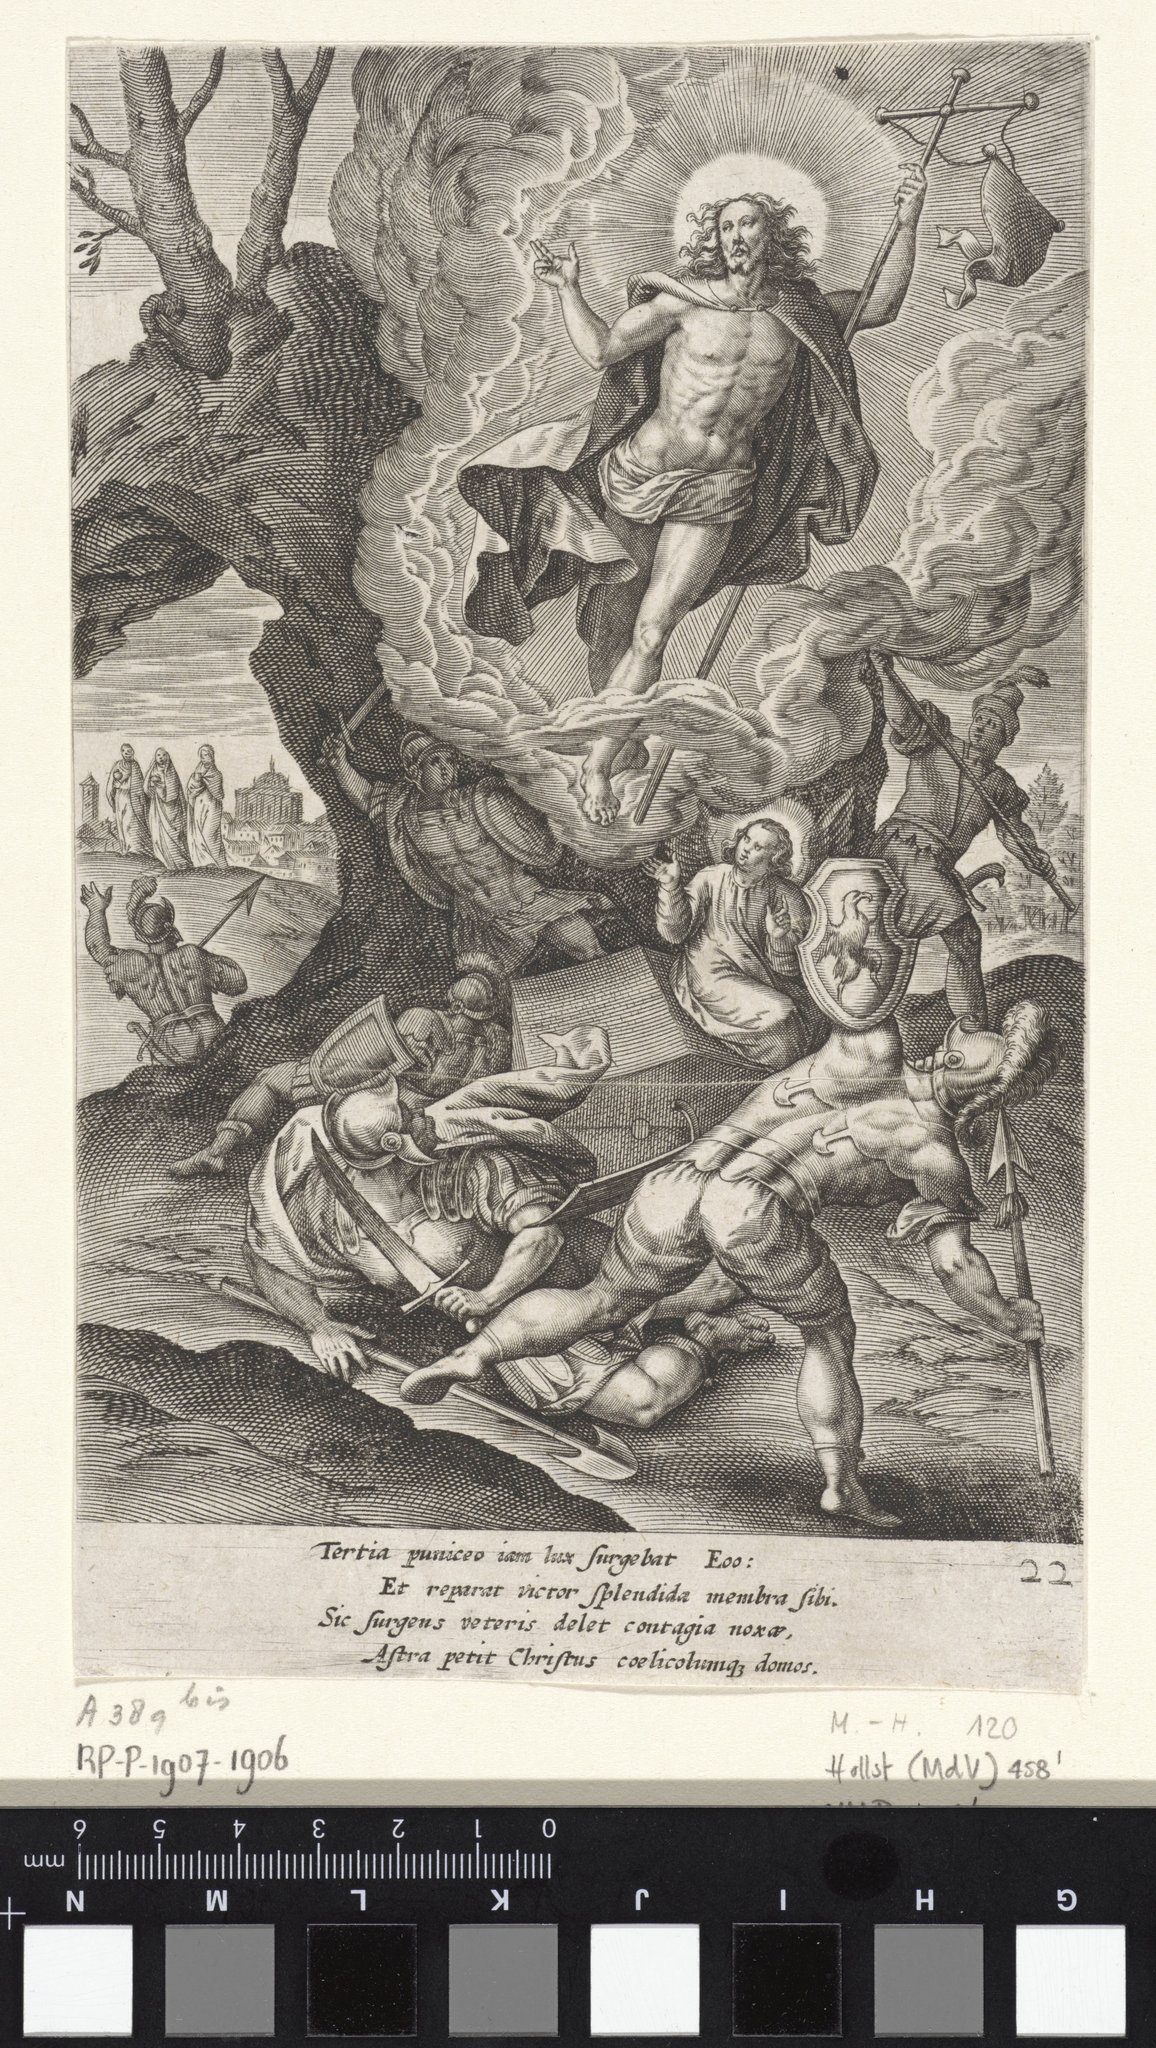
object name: print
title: Opstanding van Christus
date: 1583-1587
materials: paper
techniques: engraving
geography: antwerp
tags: the holy women (the three maries) on their way to or at the tomb, to anoint christ's body, christ, usually holding a banner, arises from the grave; often combined with sleeping and/or frightened soldiers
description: Prent gebruikt in: Thesaurus sacrarum historiaru[m] veteris (et novi) testame[n]ti, elega[n]tissimis imaginibus expressu[m] excelle[n]tissimoru[m] in hac arte viroru[m] opera : nu[n]c primu[m] in luce[m] editus. Antwerpen: Gerard de Jode, 1585.